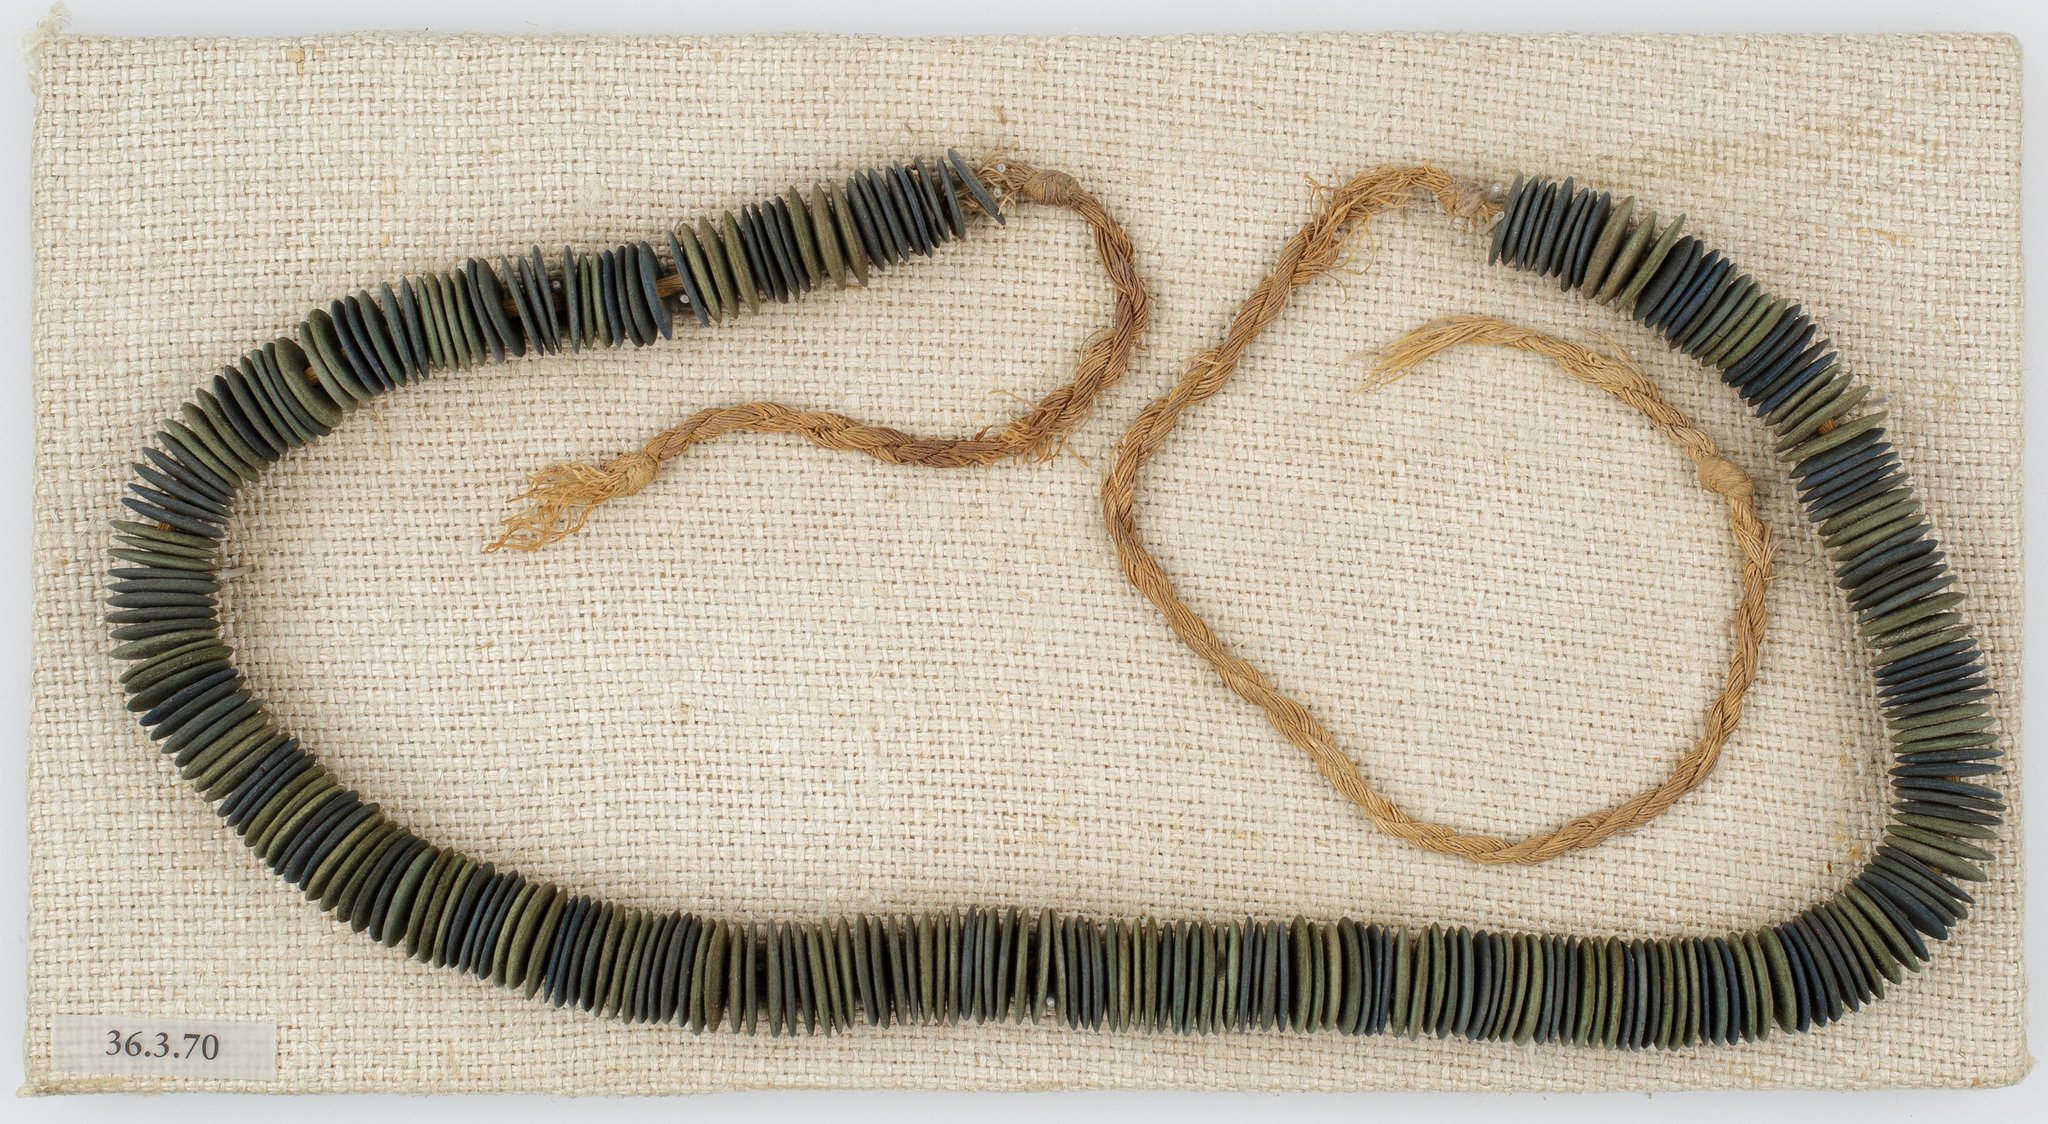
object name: necklace, lentoid bead, linen cord, shebiu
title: Shebiu Necklace of Hatnefer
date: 1492-1473 BCE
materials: cord, faience, linen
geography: egypt